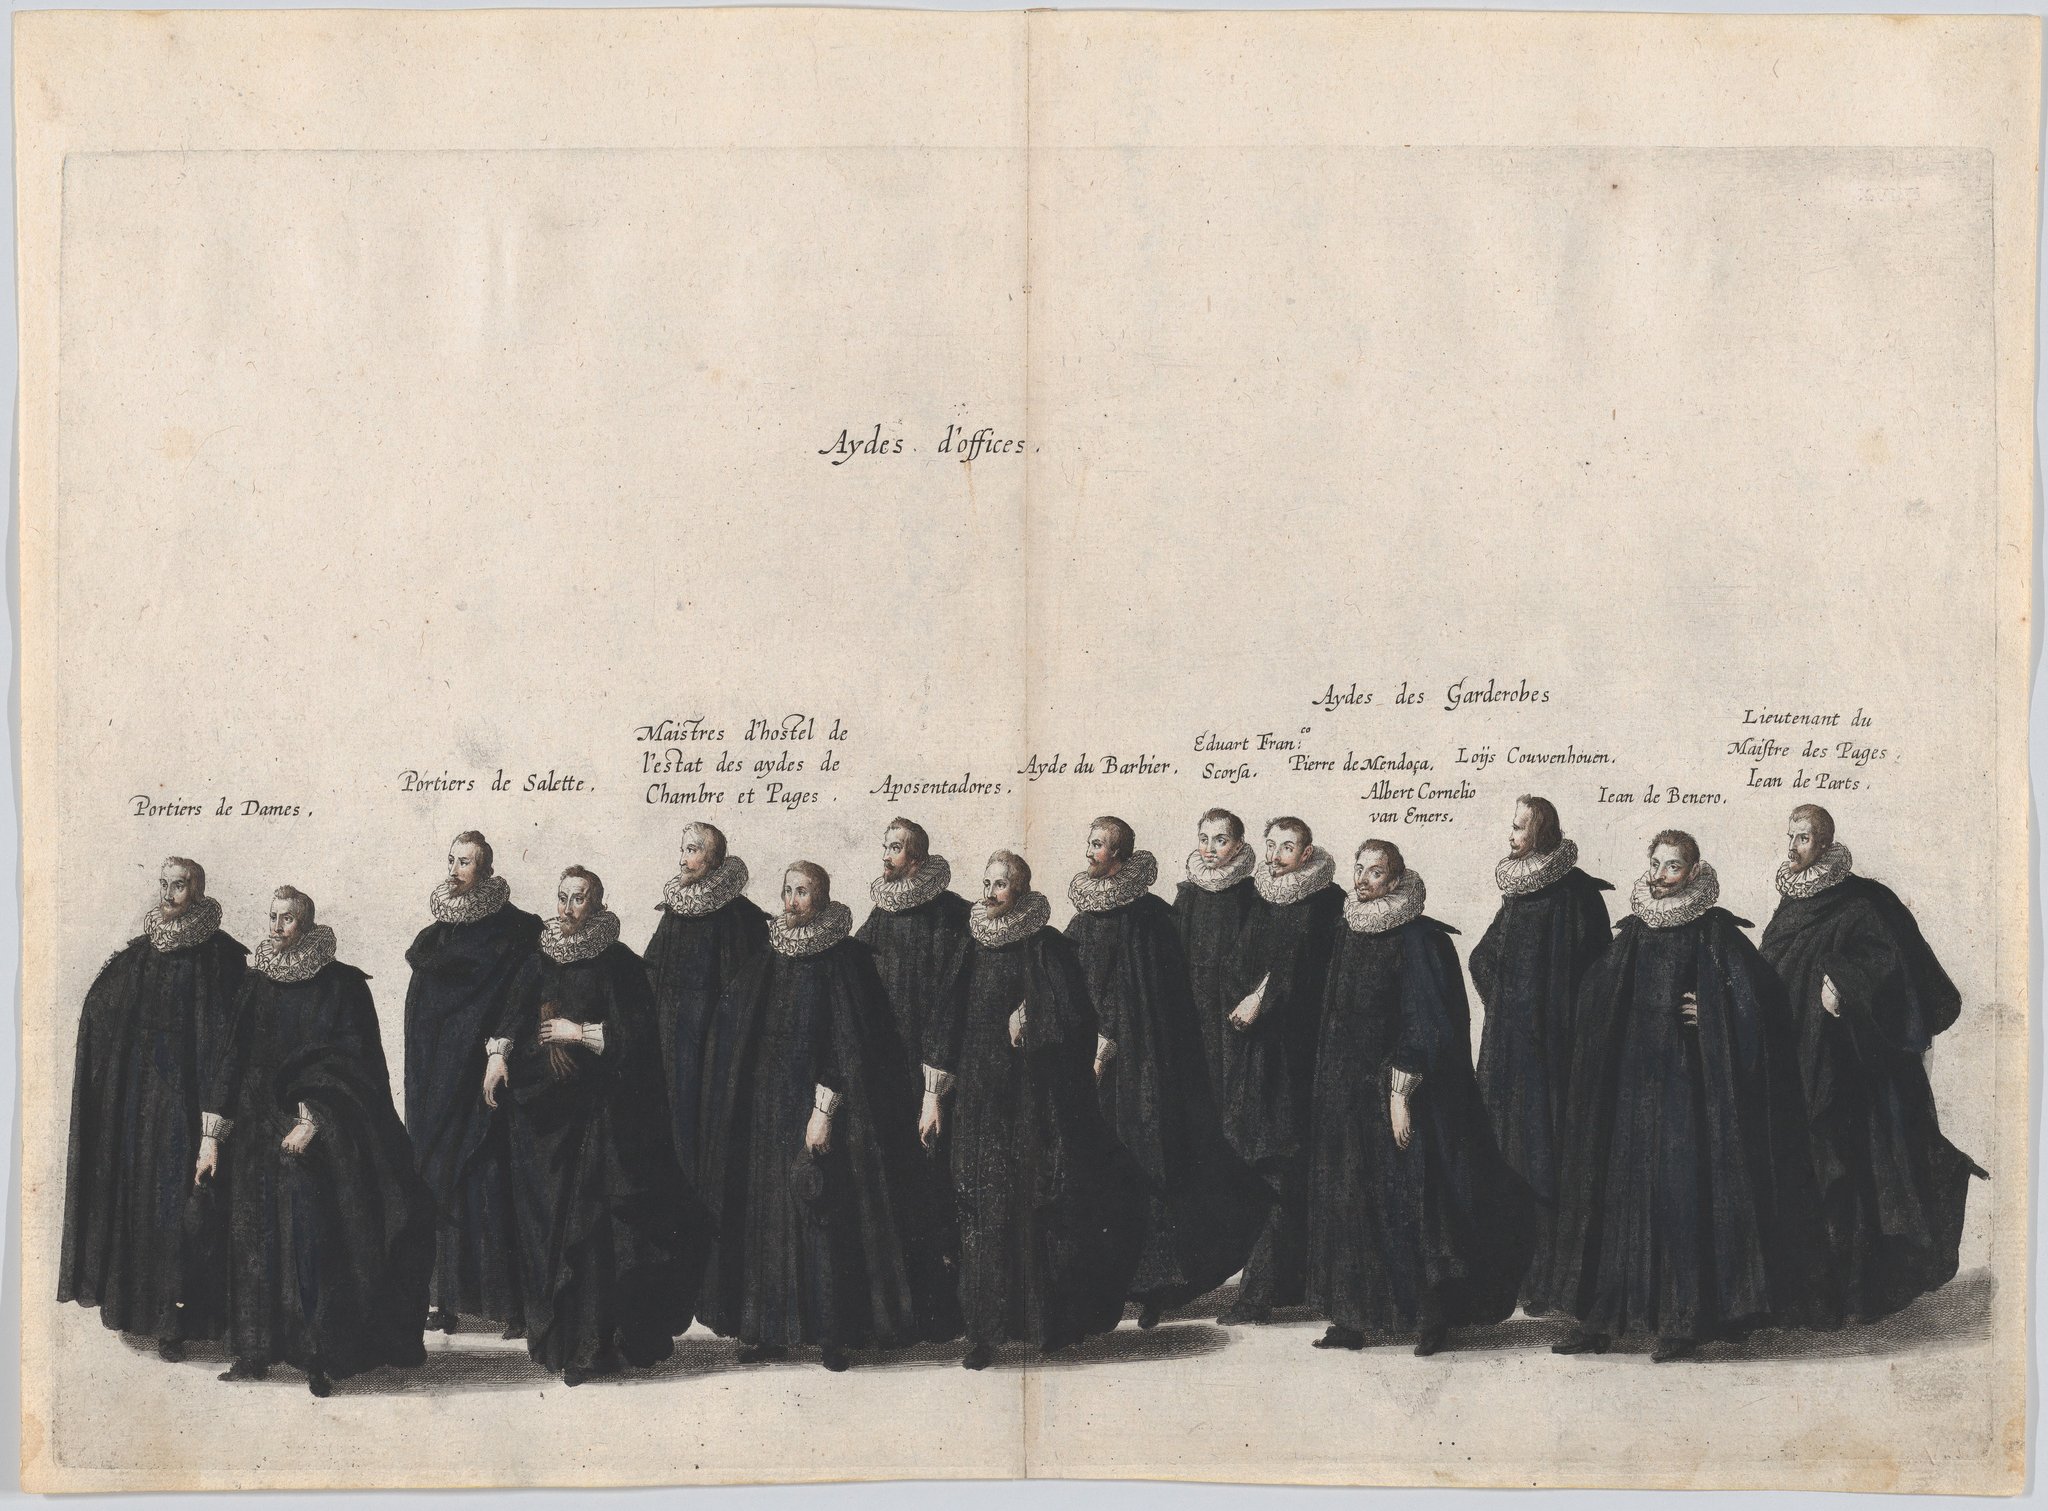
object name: print, fete, ornament architecture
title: Plate 19: Aides marching in the funeral procession of Archduke Albert of Austria; from 'Pompa Funebris ... Alberti Pii'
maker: cornelis galle (i)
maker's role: artist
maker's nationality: netherlandish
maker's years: 1576-1650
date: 1623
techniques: etching, hand coloring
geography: brussels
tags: men